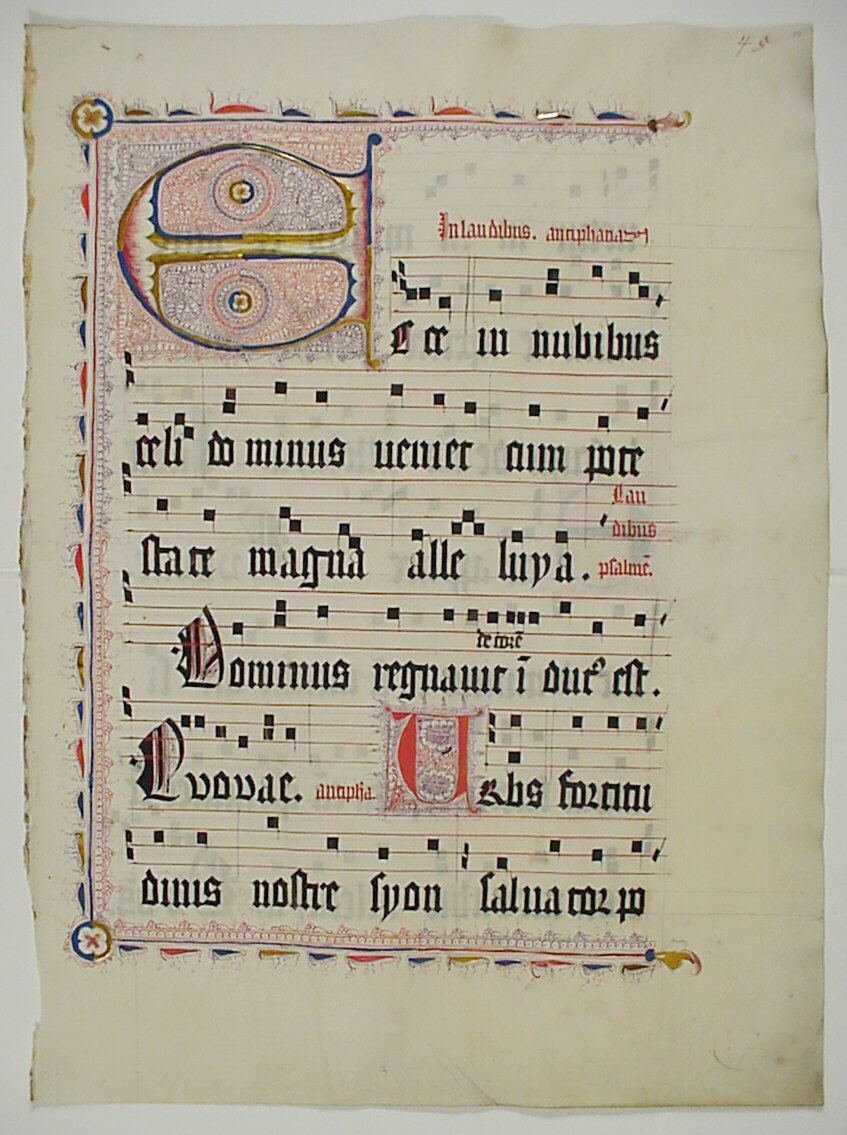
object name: antiphonary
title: Manuscript Leaf with Initial E, from an Antiphonary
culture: german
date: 1426-1450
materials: ink, metal leaf, parchment, paint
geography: germany